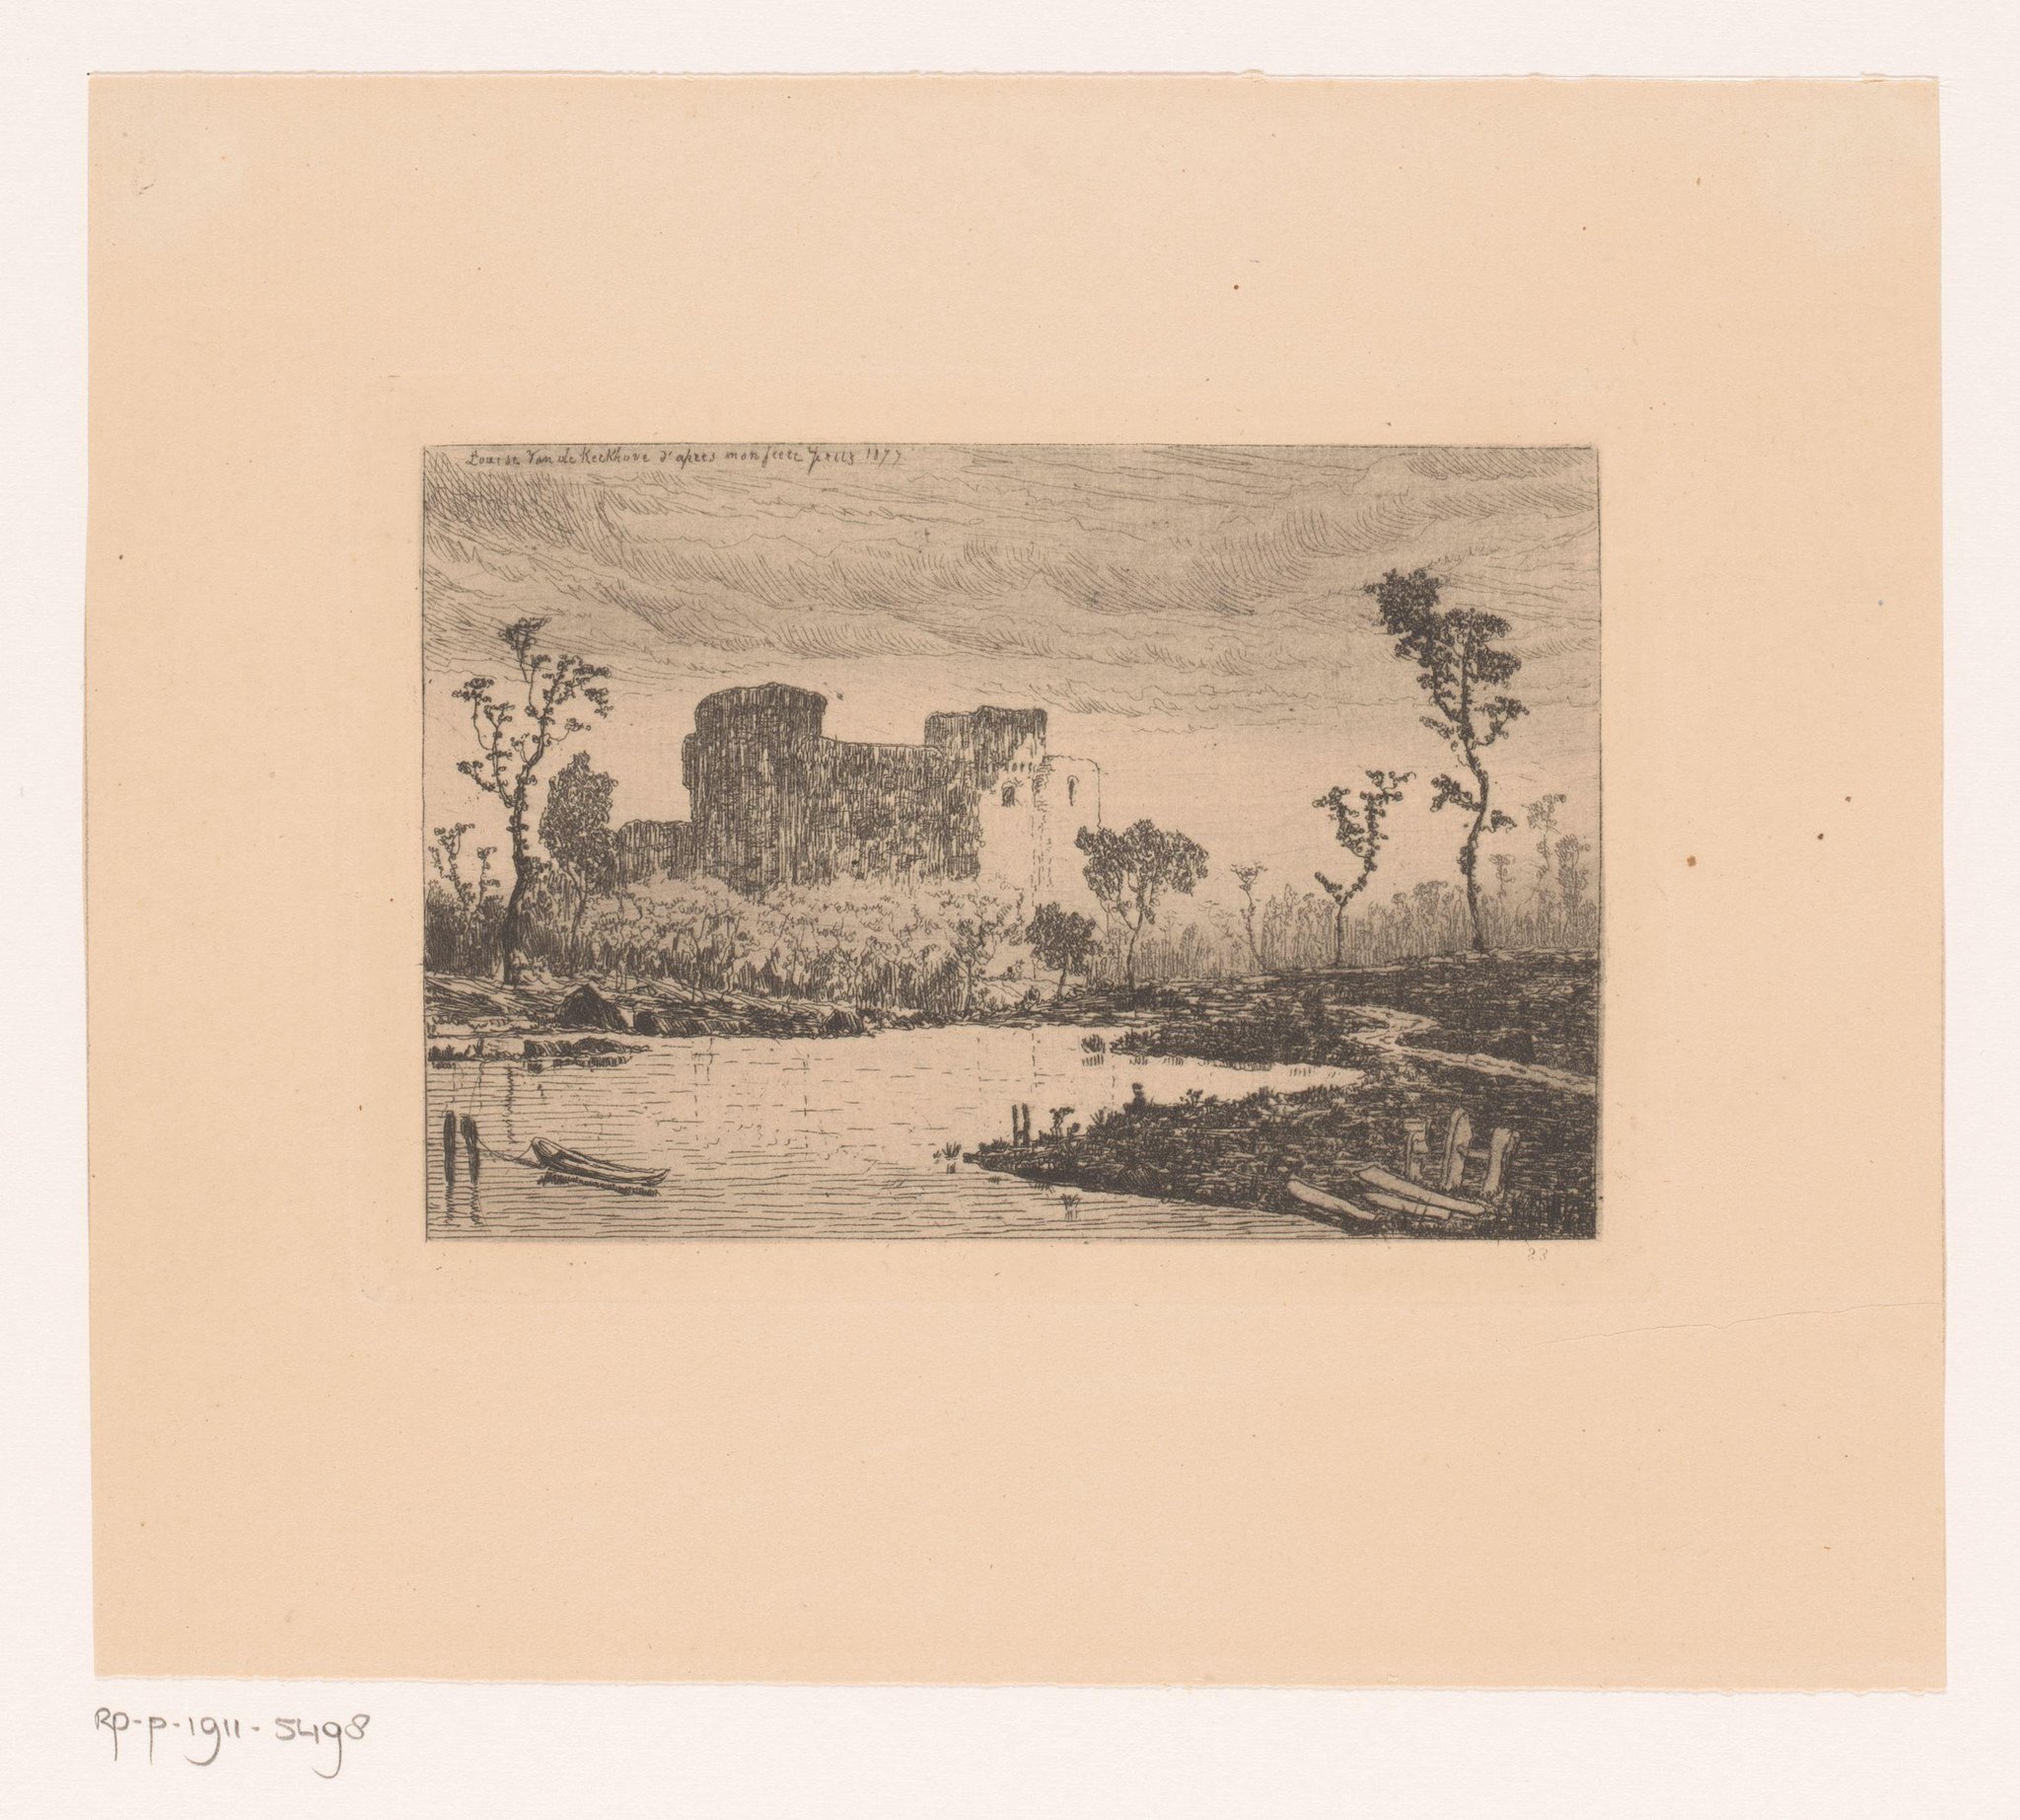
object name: print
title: Rivierlandschap met kasteelruïne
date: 1877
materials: paper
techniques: etching, intaglio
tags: river, ruin of a dwelling, house, castle, etc.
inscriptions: collector's mark: Lugt 2228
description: De etsen naar de schilderijen van Frédéric Van de Kerkhove werden na zijn dood door zijn vader en zuster gemaakt en uitgegeven in twee reeksen. De eerste werd in 1877 uitgegeven door het Journal des Beaux-Arts et de la Littérature: Cahier de 25 Eaux-fortes d'après Frédéric van de Kerkhove, gravées par son père et sa sœur. De tweede reeks van 126 etsen, ook in 1877, werd in Parijs uitgegeven bij A. Lévy onder de titel Cent eaux-fortes gravées par J. Van de Kerkhove d'après les tableaux de Frédéric Van de Kerkhove, mort en 1873 à l'âge de 10 ans et 11 mois.